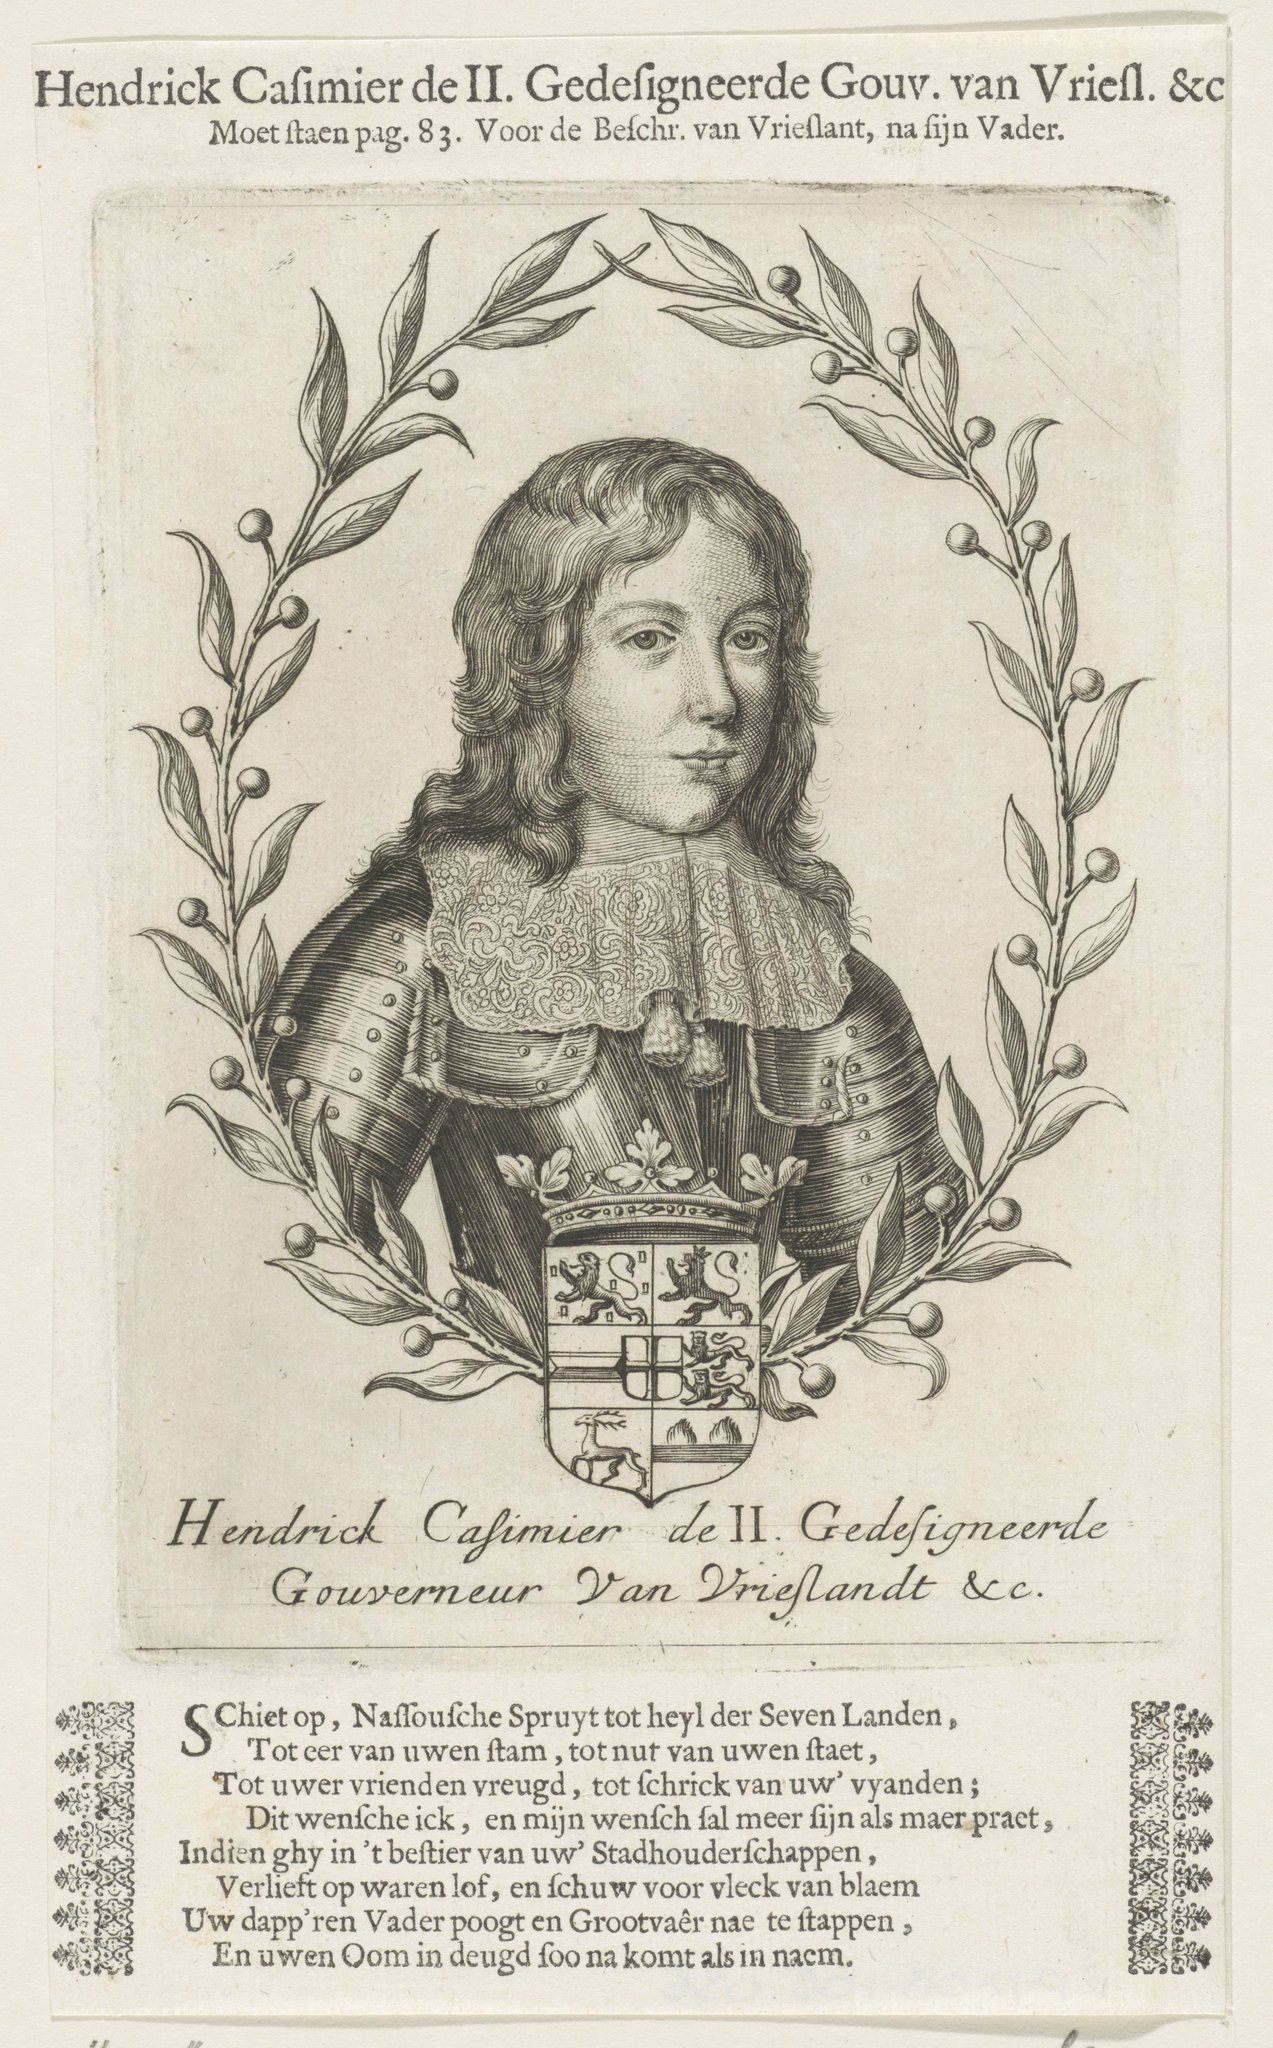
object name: book illustration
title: Portret van Hendrik Casimir II, graaf van Nassau-Dietz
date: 1667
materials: paper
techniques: engraving, etching, letterpress printing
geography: the hague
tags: the hague, hendrik casimir ii graaf van nassau-dietz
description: De hier vermelde titel verwijst naar de hoogst verkregen titel van de geportretteerde, niet per se naar de titel die de geportretteerde op deze voorstelling draagt. Prent uit: Scriverius, Petrus. Oude en nieuwe beschryvinghe van Holland, Zeeland en Vriesland. Den Haag: Levijn van Dijck, 1667.